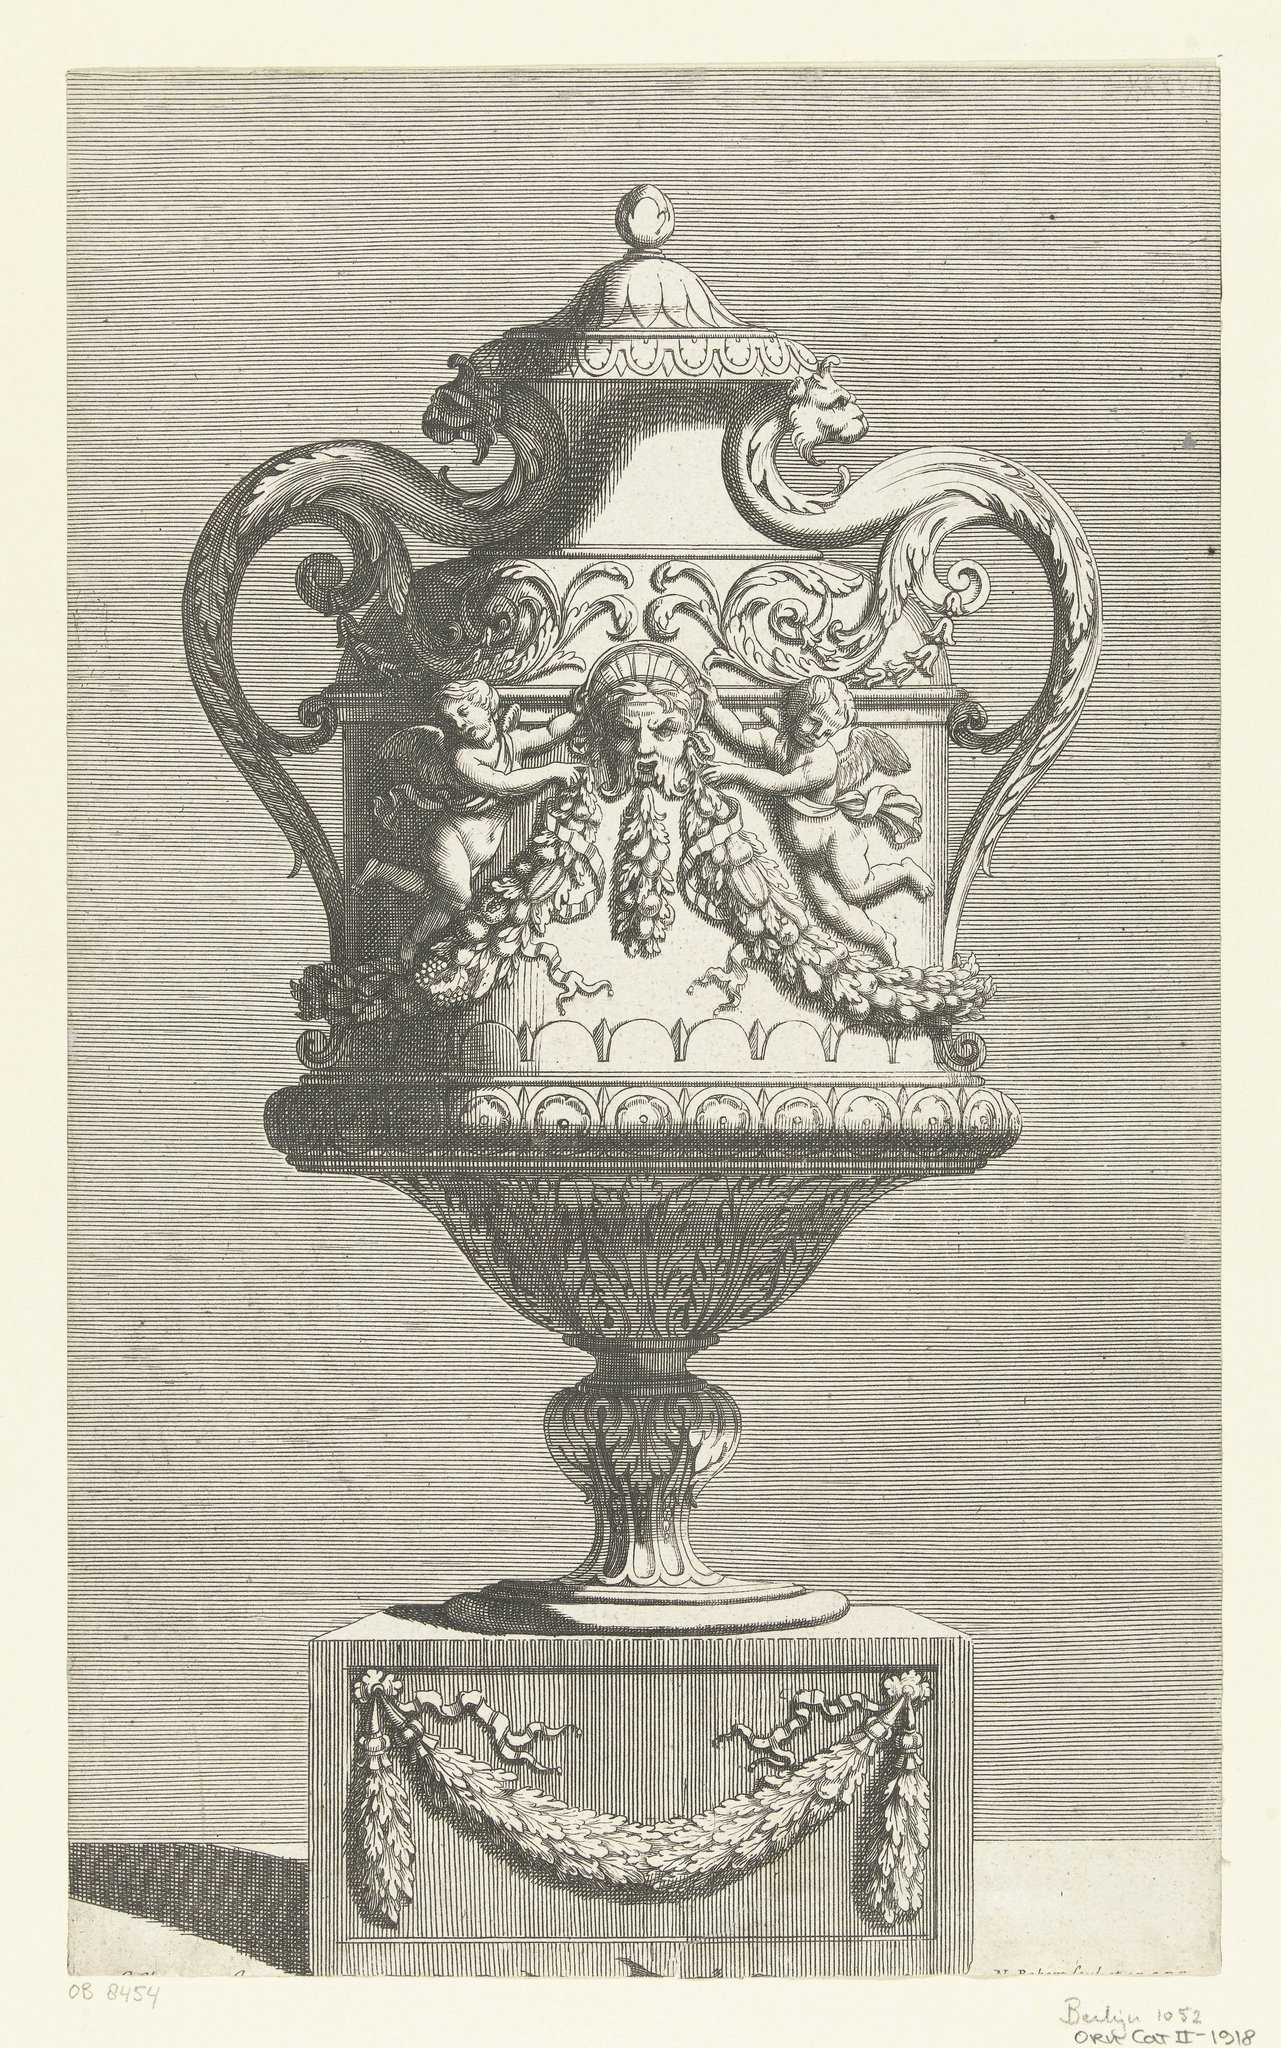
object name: print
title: Plusieurs Vaze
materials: paper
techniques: engraving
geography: france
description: De vaas heeft handvatten in de vorm van bladranken eindigend in leeuwenkoppen en staat op een voetstuk met guirlandes van bladeren.